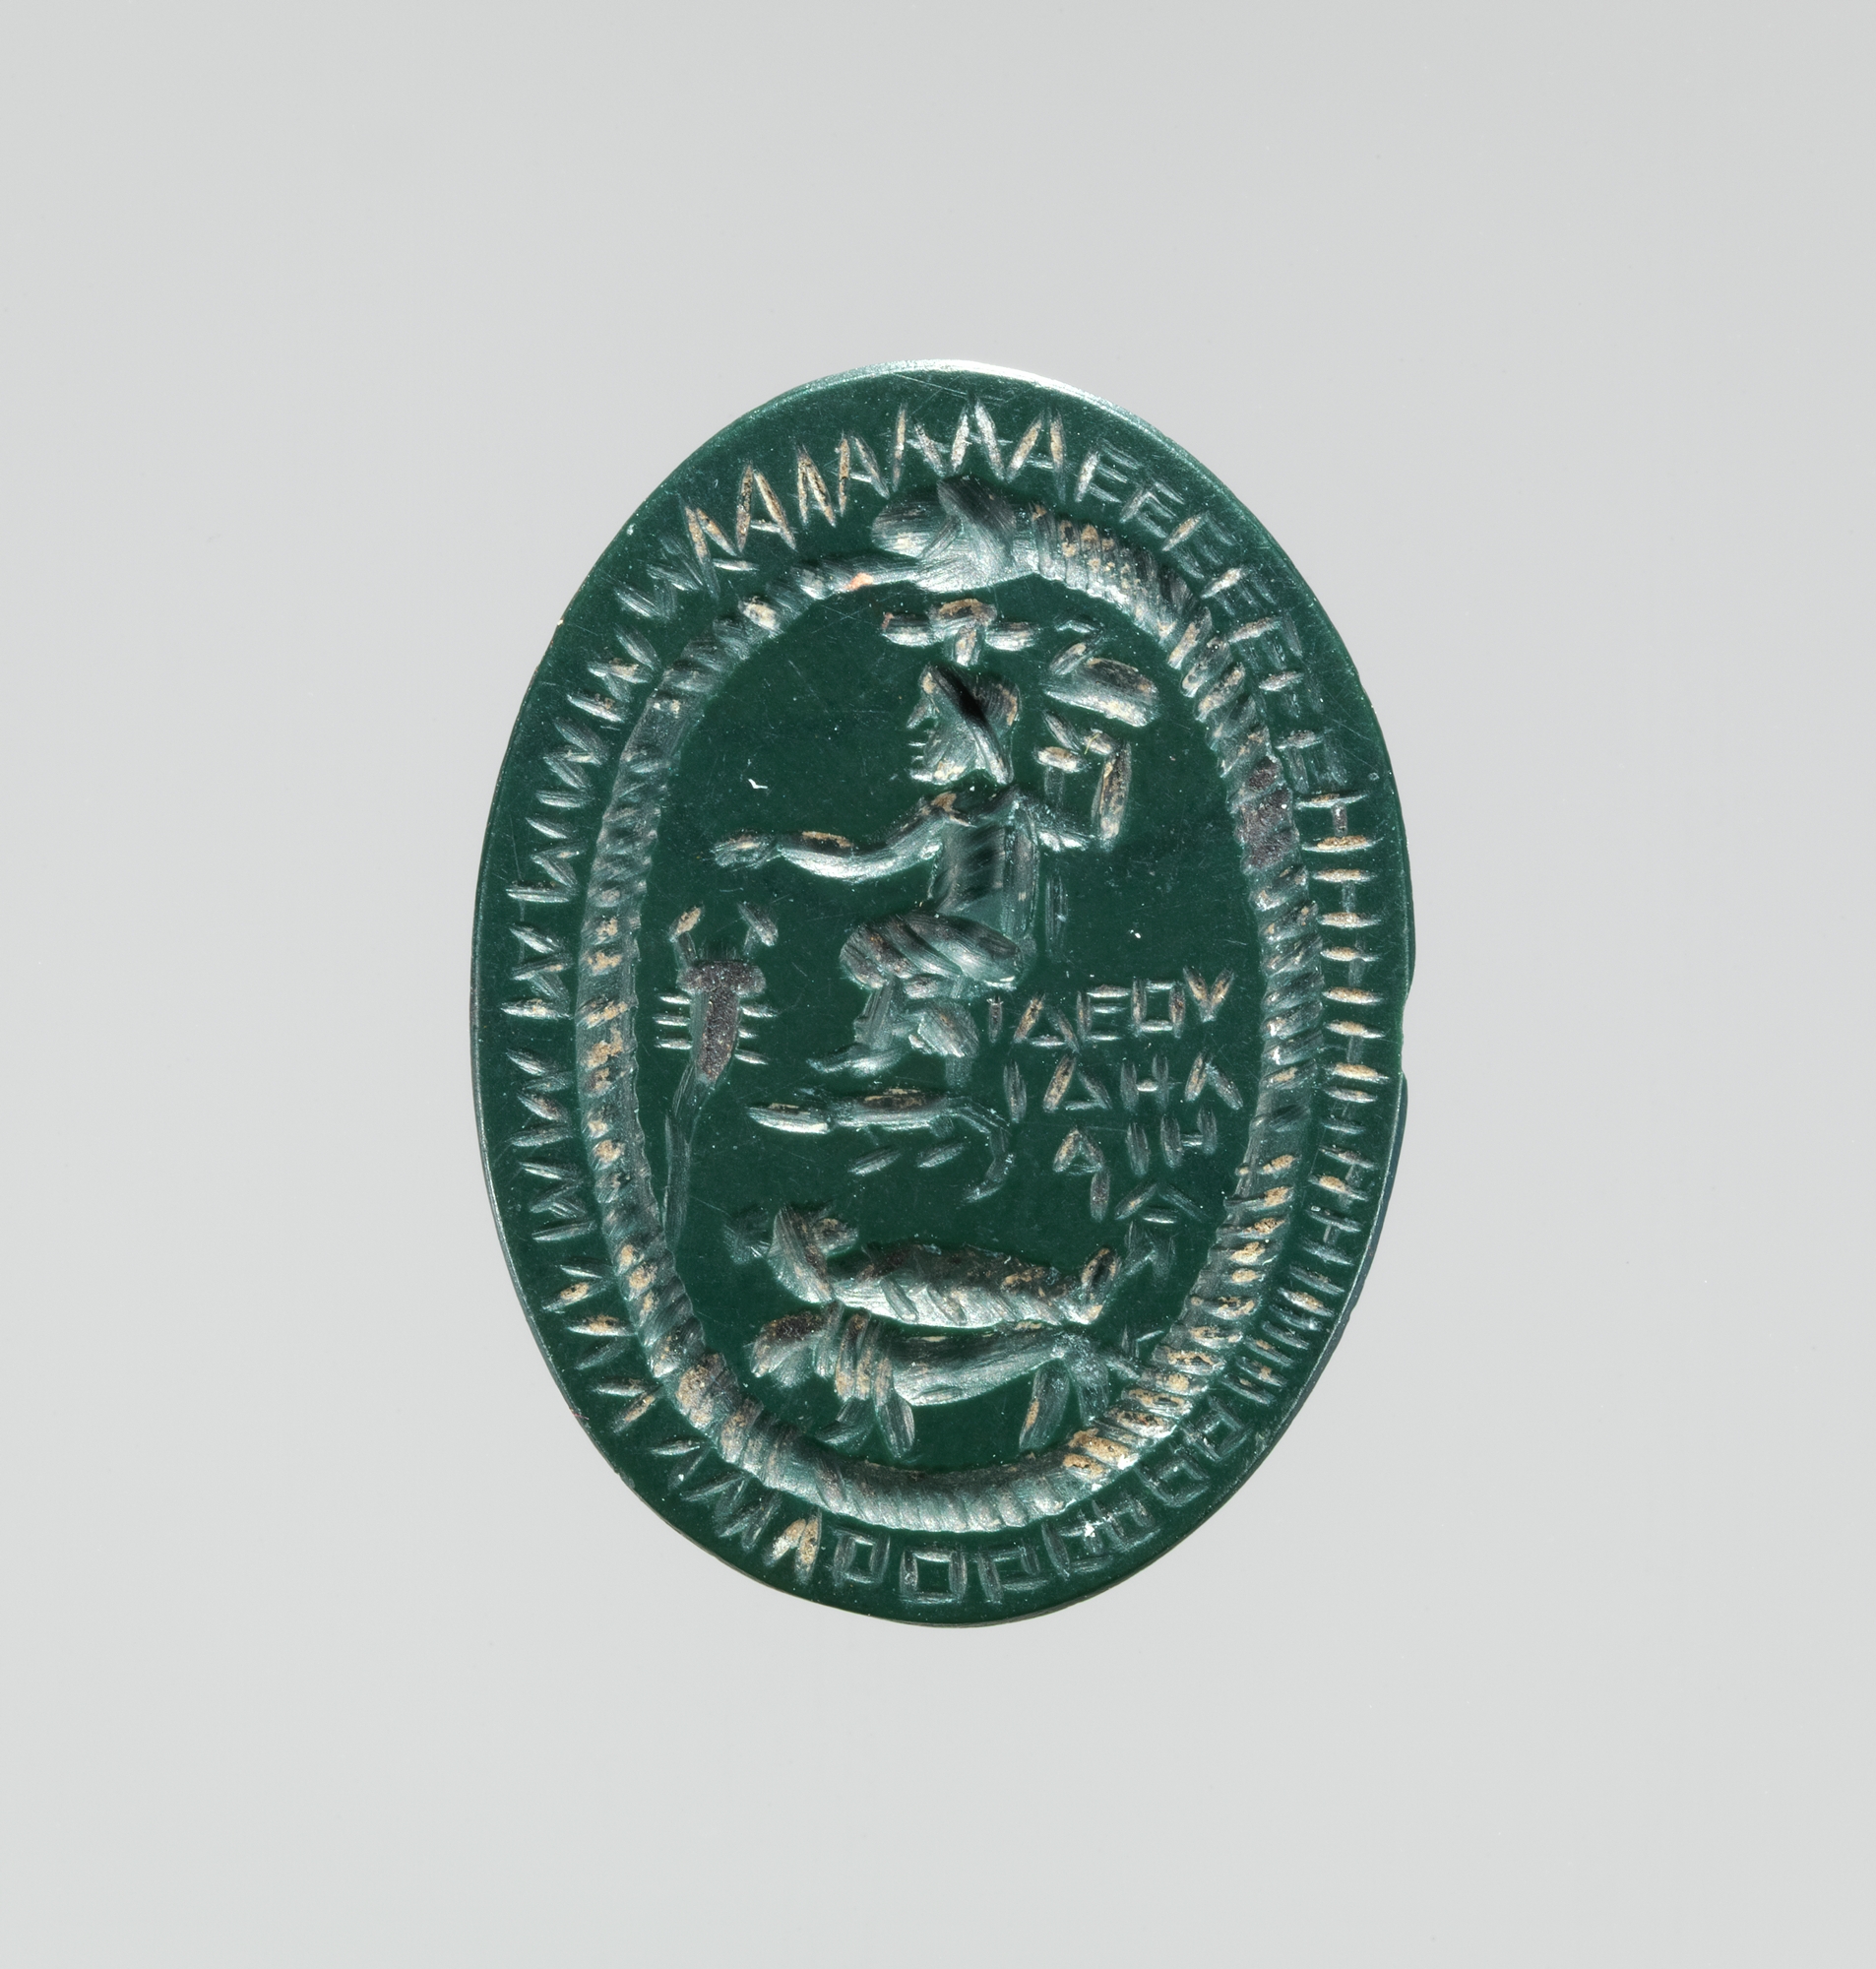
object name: intaglio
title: Jasper intaglio: Seated Serapis on crocodile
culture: roman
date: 101-200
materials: jasper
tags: hawks,crocodiles,scarabs